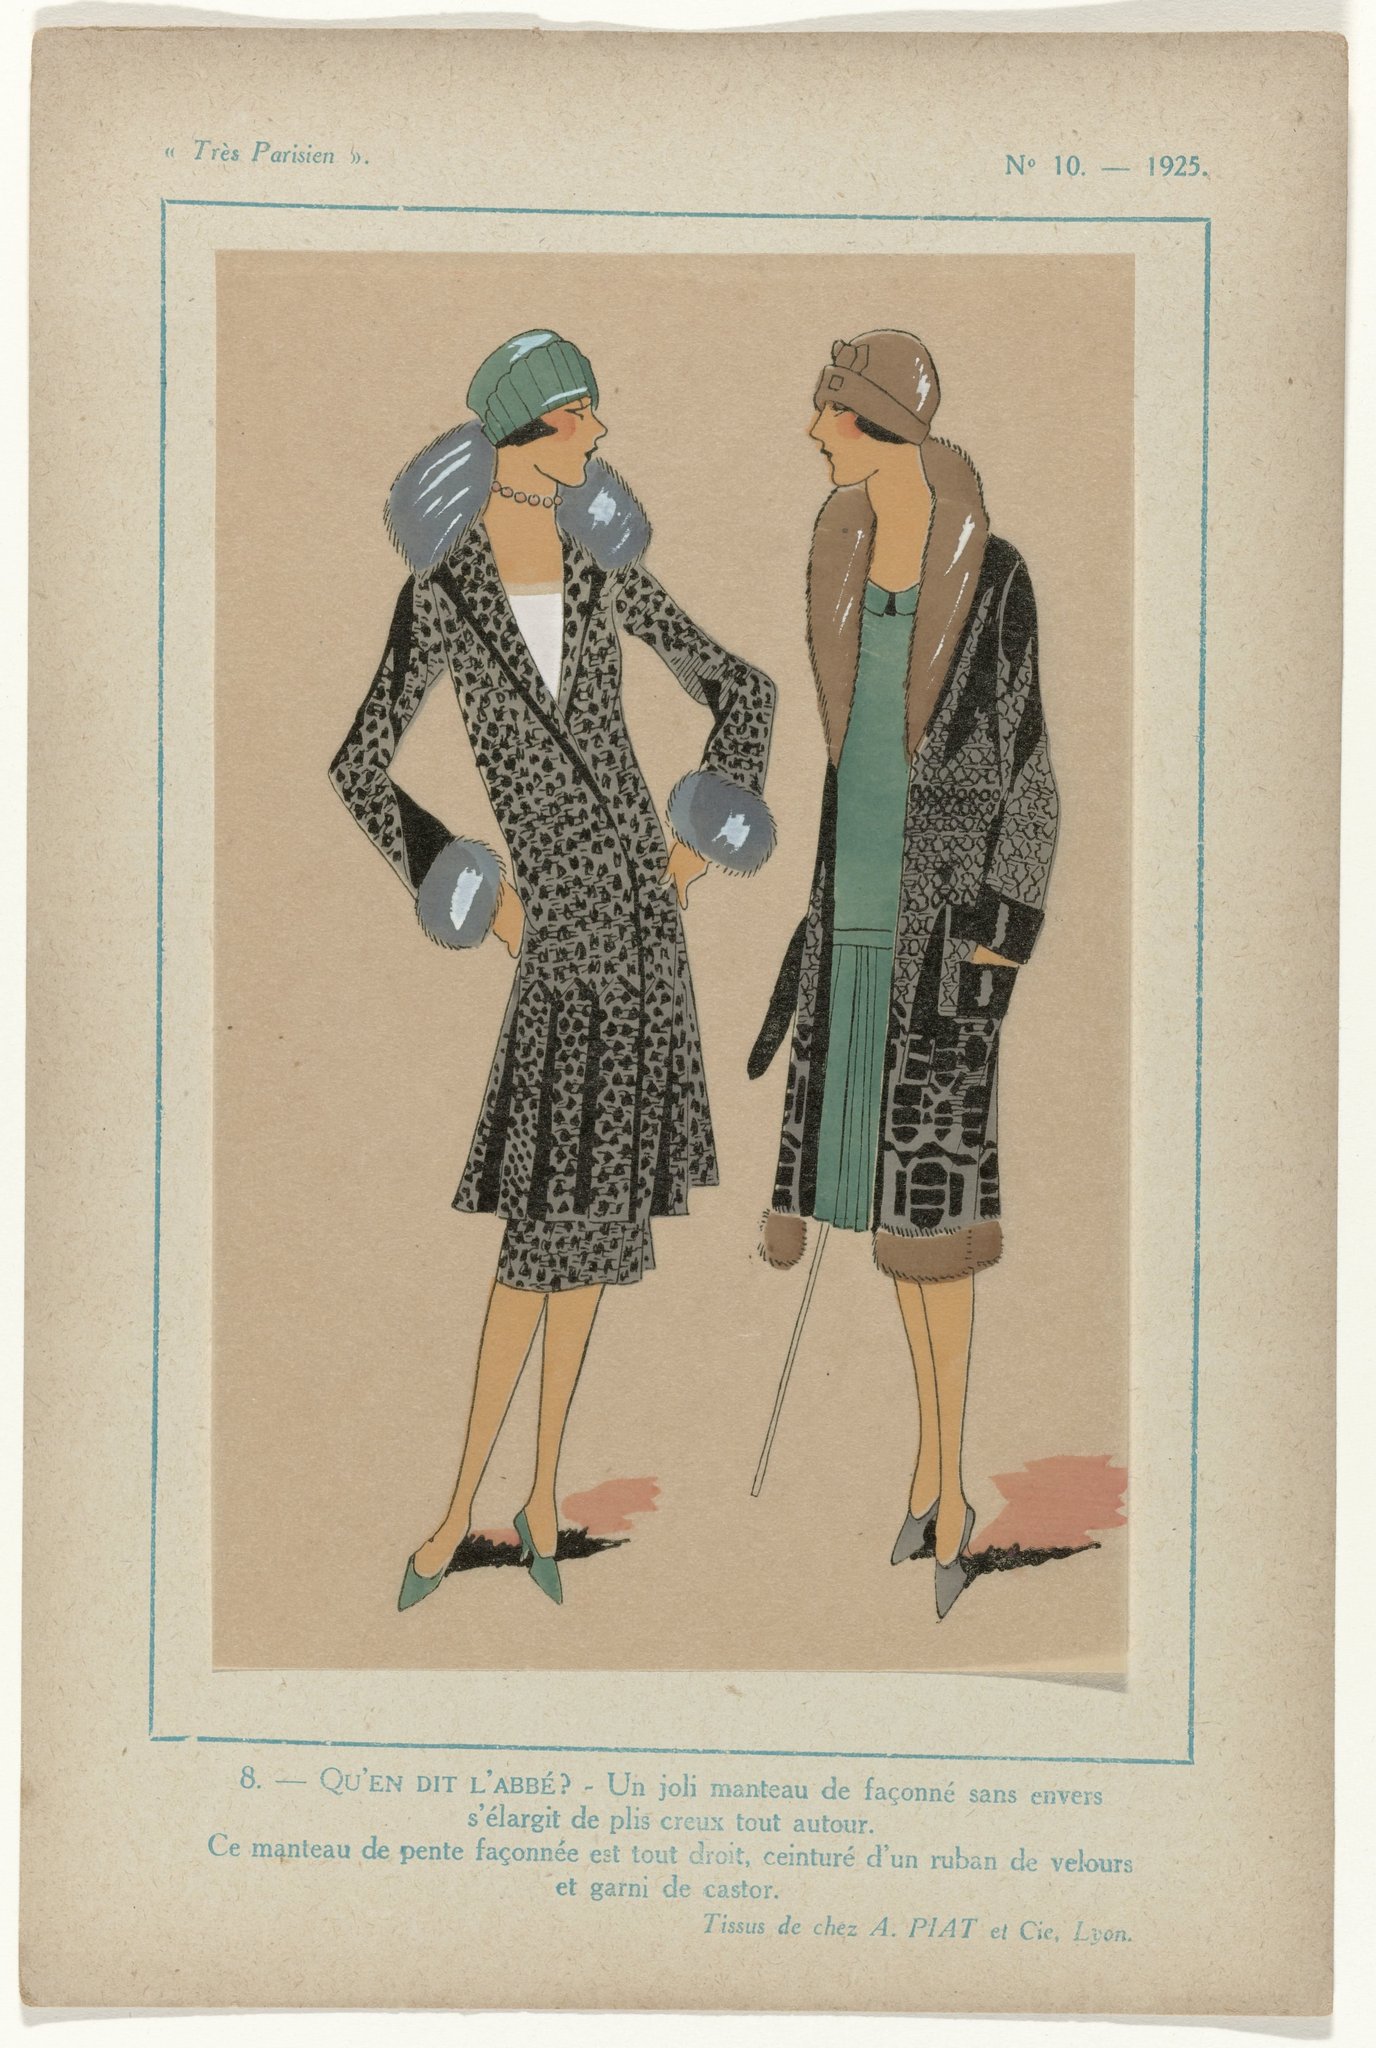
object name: fashion print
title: Très Parisien, 1925, No. 10, Pl. 8: - QU'EN DIT L'ABBÉ ?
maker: g-p. joumard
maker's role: publisher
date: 1925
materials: paper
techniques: hand coloring, letterpress printing, lithography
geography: paris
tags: coat (+ women's clothes), fashion plates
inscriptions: caption: ‘QU'EN DIT L'ABBÉ ? Un joli manteau de faconné sans envers s'élargit de plis creux tour autour / Ce manteau de pente façonnée est tout droit, ceinturé d'un ruban de velours et garni de castor.’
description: Twee mantels, een met plooien en een recht vallende mantel met ceintuur. Stoffen van A Piat, Lyon. Prent uit het modetijdschrift Très Parisien...La Mode, Le Chic, L'Élégance (1920-1936)